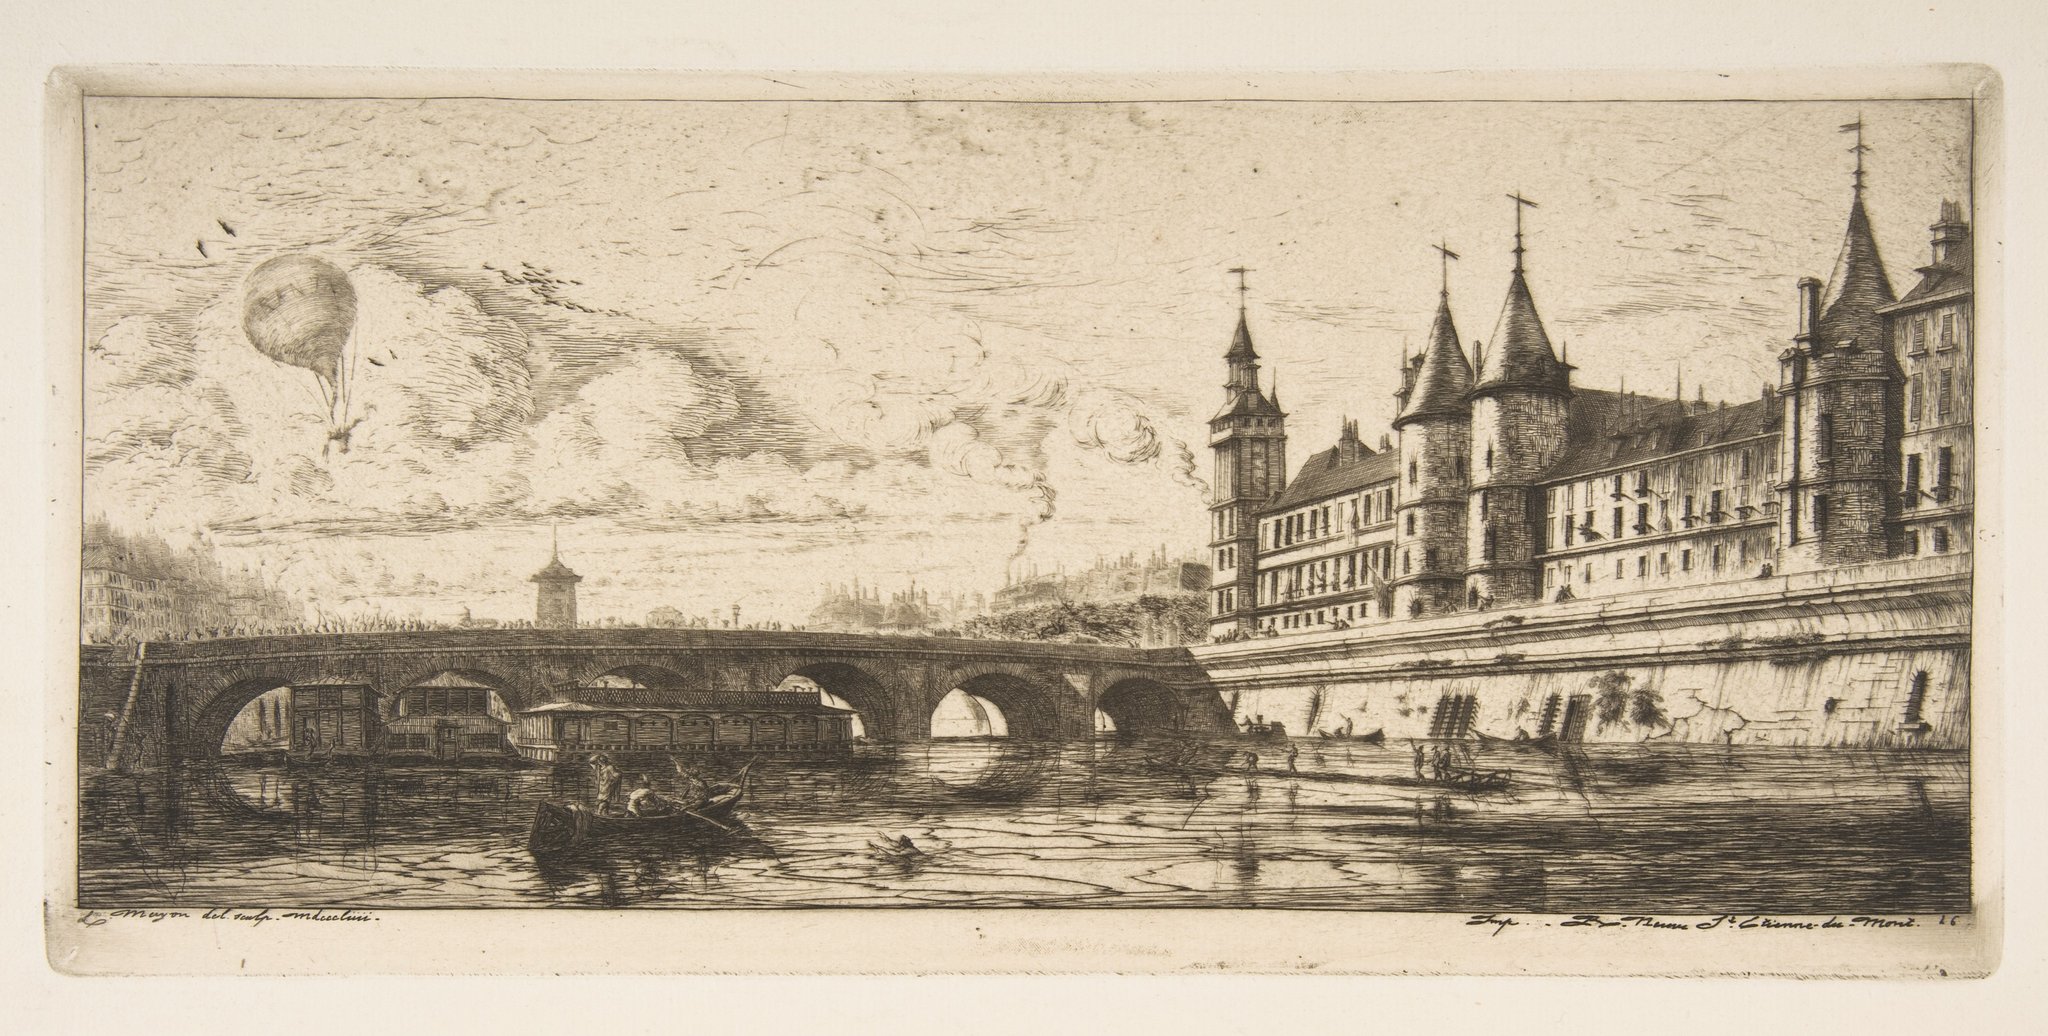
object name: print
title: Pont-au-Change, Paris, from "Etchings of Paris"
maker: charles meryon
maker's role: artist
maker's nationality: french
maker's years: 1821-1868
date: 1854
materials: paper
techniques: drypoint, etching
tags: buildings,bridges,rivers,boats,paris